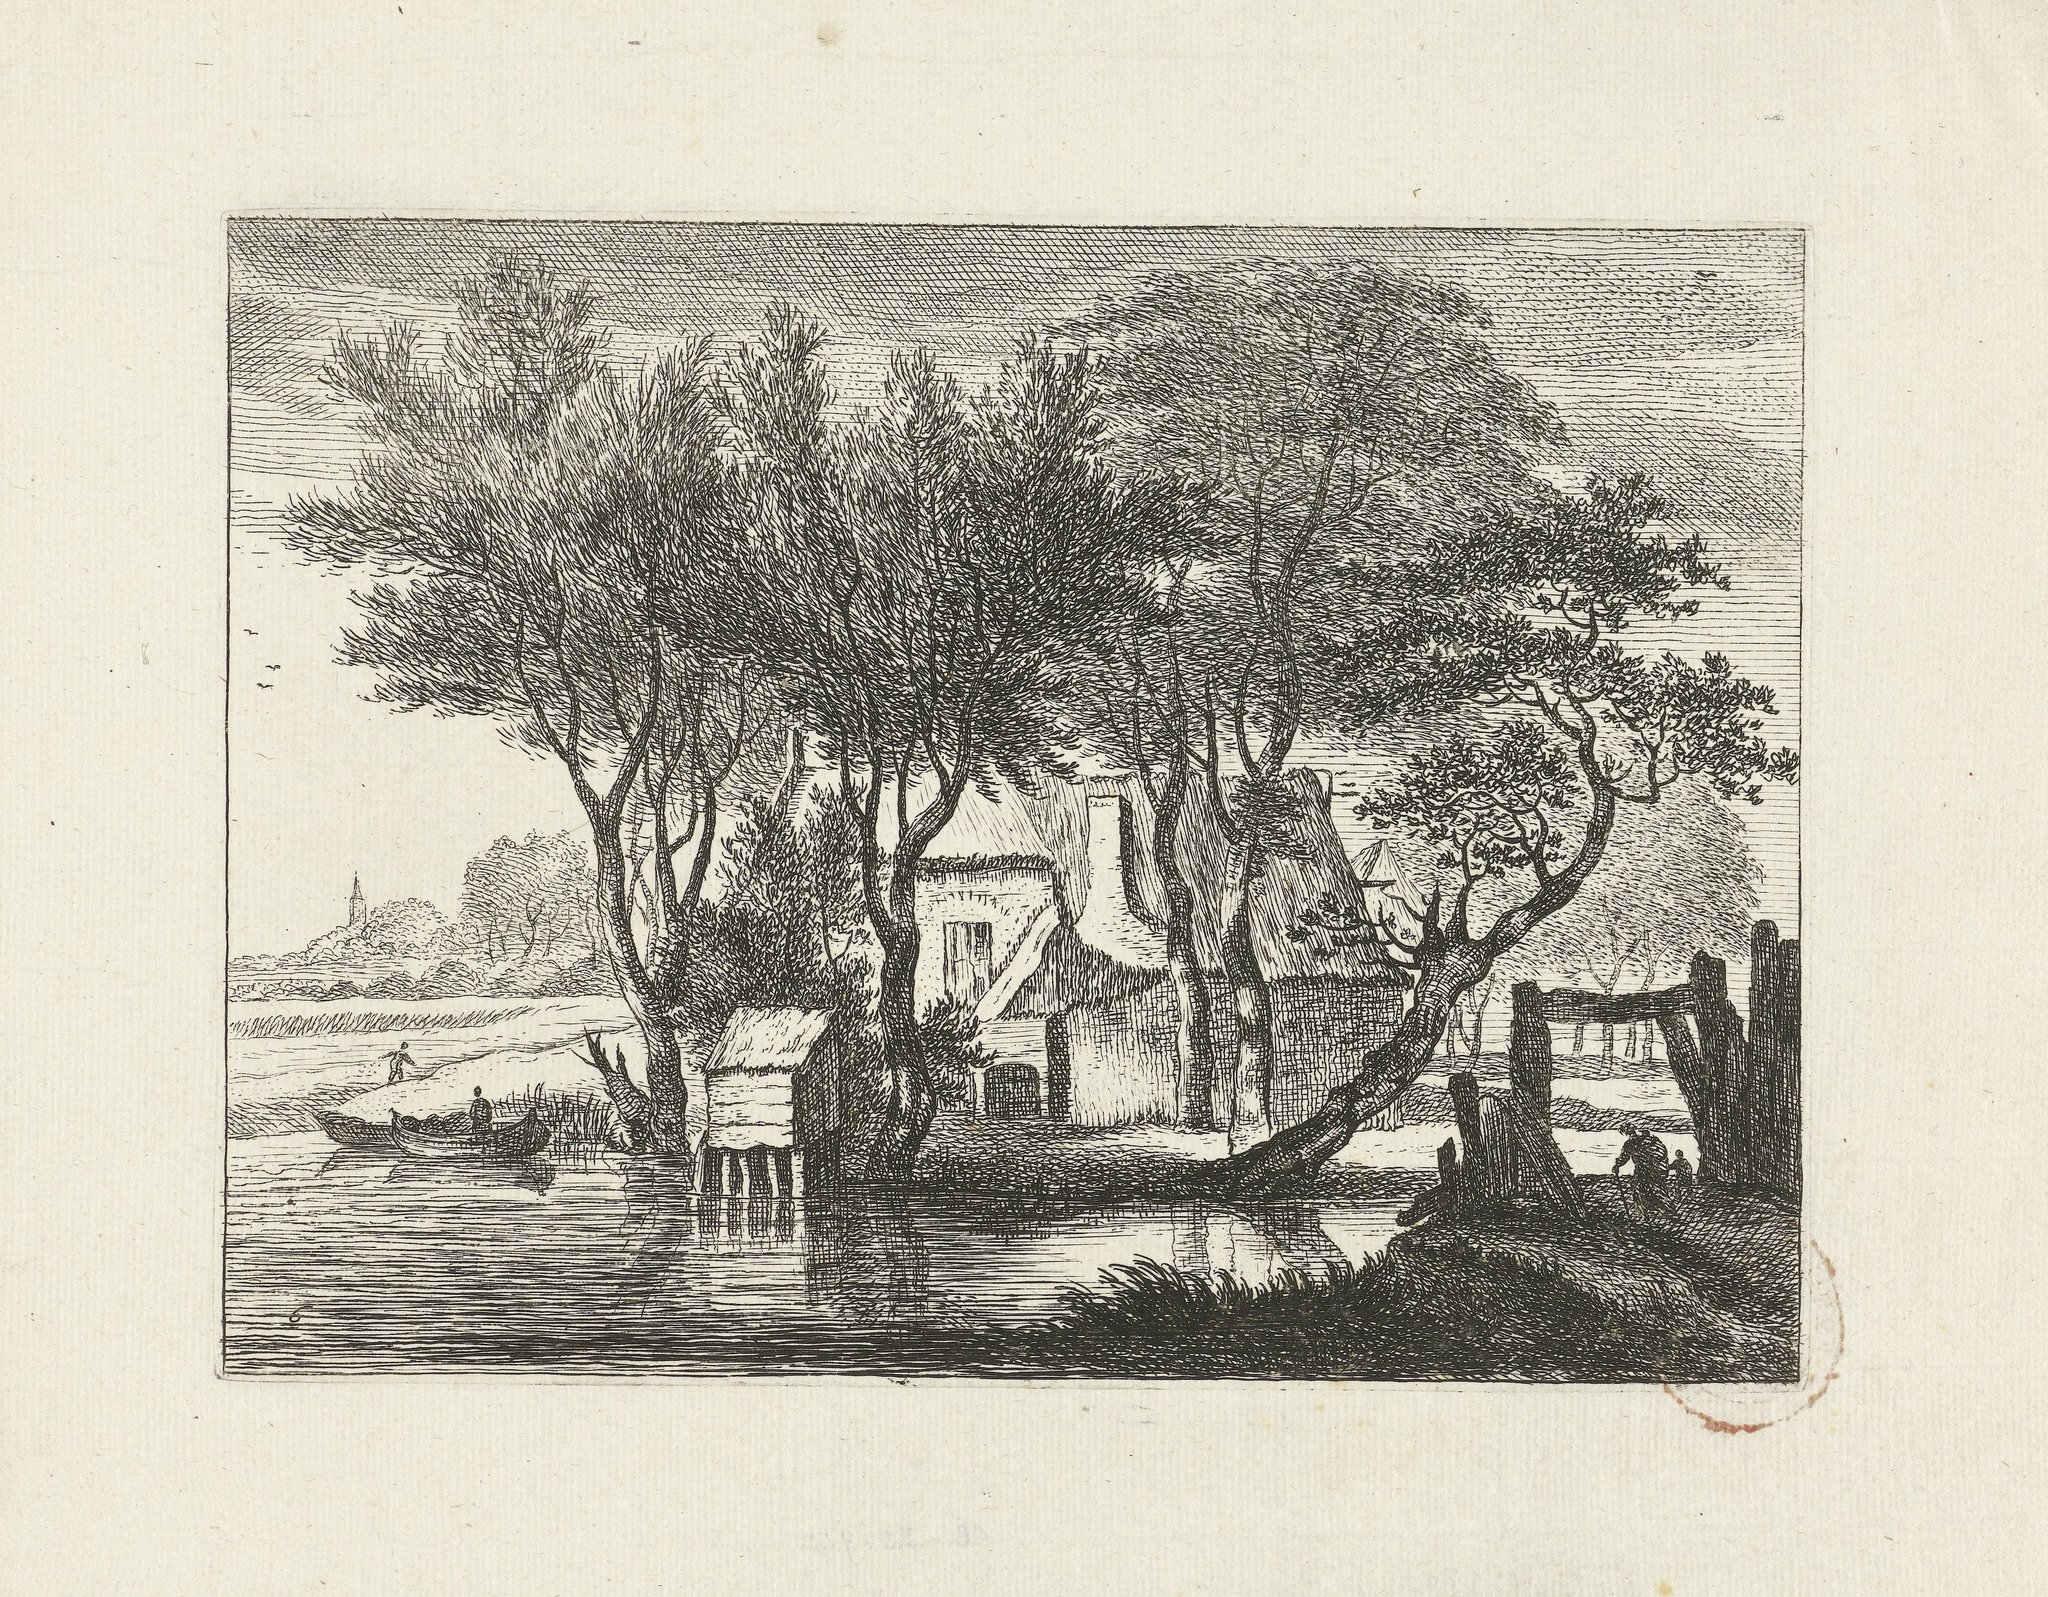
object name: print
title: Landschappen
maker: johannes gronsveld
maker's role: draughtsman, painter, print maker, publisher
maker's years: 1658-1728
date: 1679-1728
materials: paper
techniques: engraving, etching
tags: farm or solitary house in landscape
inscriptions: collector's mark: Lugt 240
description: Boslandschap met boerderij omgeven door bomen, gelegen aan het water. Rechts op de voorgrond twee wandelaars op landweg en links op de achtergrond een kerk. Zesde prent uit een serie van zes met landschappen.